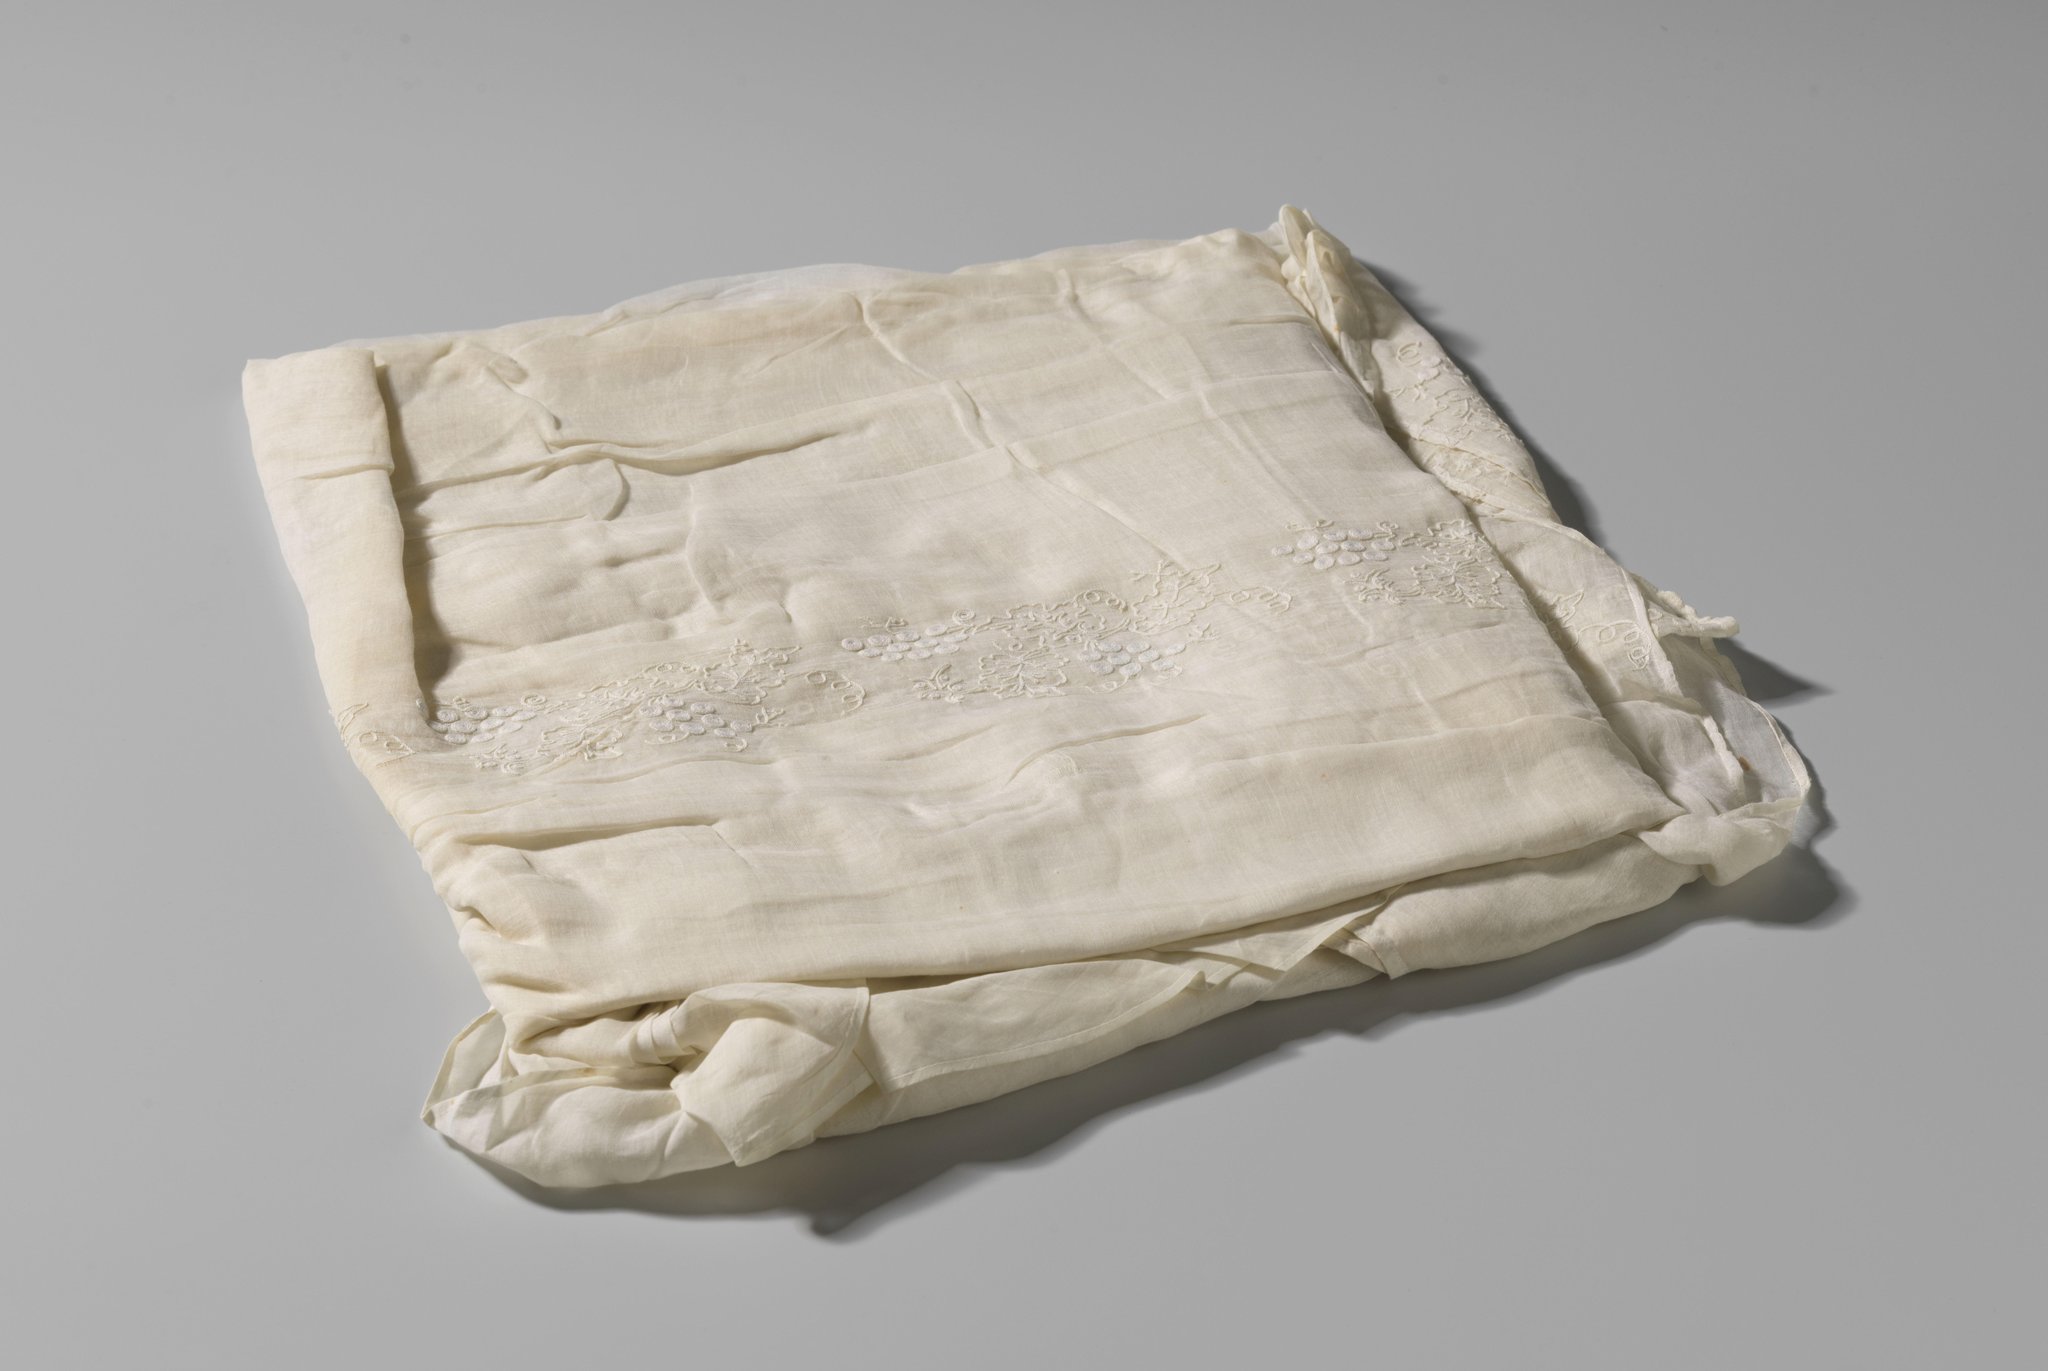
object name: curtain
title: Wiegengordijn van batist met druivenranken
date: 1830-1840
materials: textile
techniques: embroidered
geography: netherlands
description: Wiegengordijn van batist met druivenranken in wit borduurwerk.